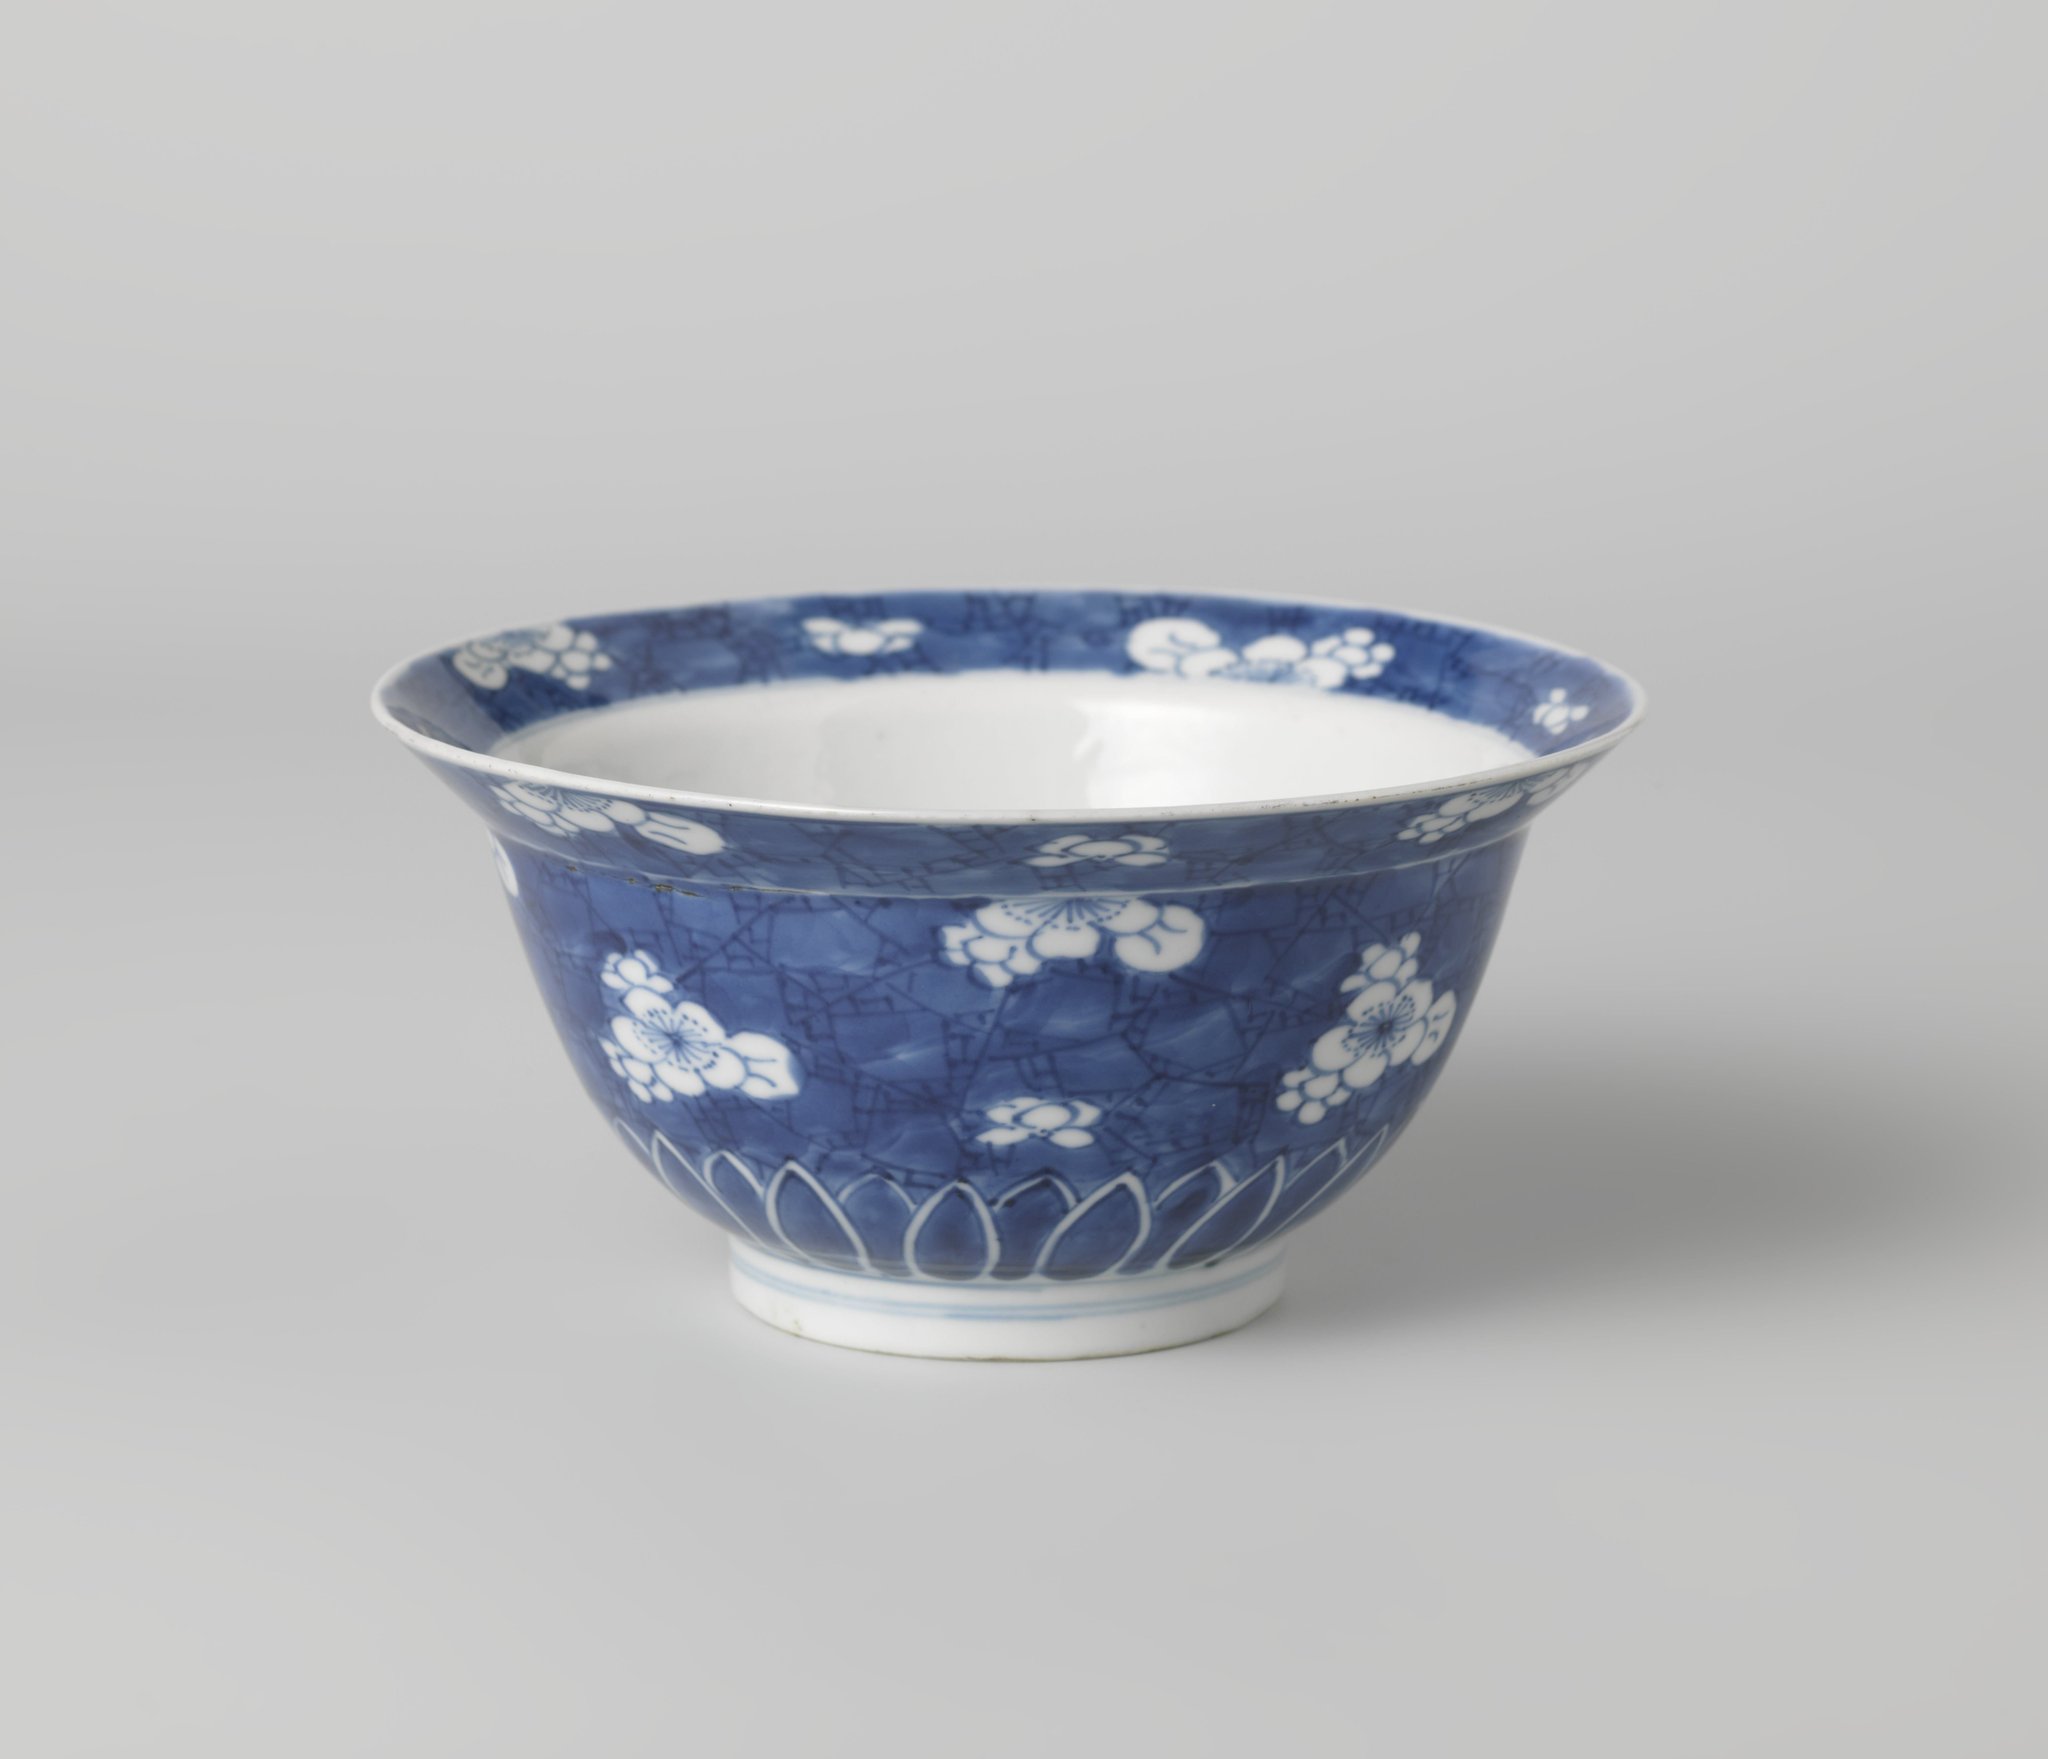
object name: bowl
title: Bowl (klapmuts) with plumblossom on 'crackled ice'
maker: Anonymous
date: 1680-1720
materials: cobalt, glaze, paint, porcelain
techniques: firing, turning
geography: china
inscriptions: mark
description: Kom (klapmuts) van porselein, beschilderd in onderglazuur blauw. Op de buitenwand, de bodem en binnen- en buitenrand 'crackled ice' met uitgespaarde pruimenbloesems. De onderzijde van de buitenwand met een band van puntige bladmotieven. Gemerkt op de onderzijde met een wierookbrander in een dubbele cirkel. Blauw-wit.